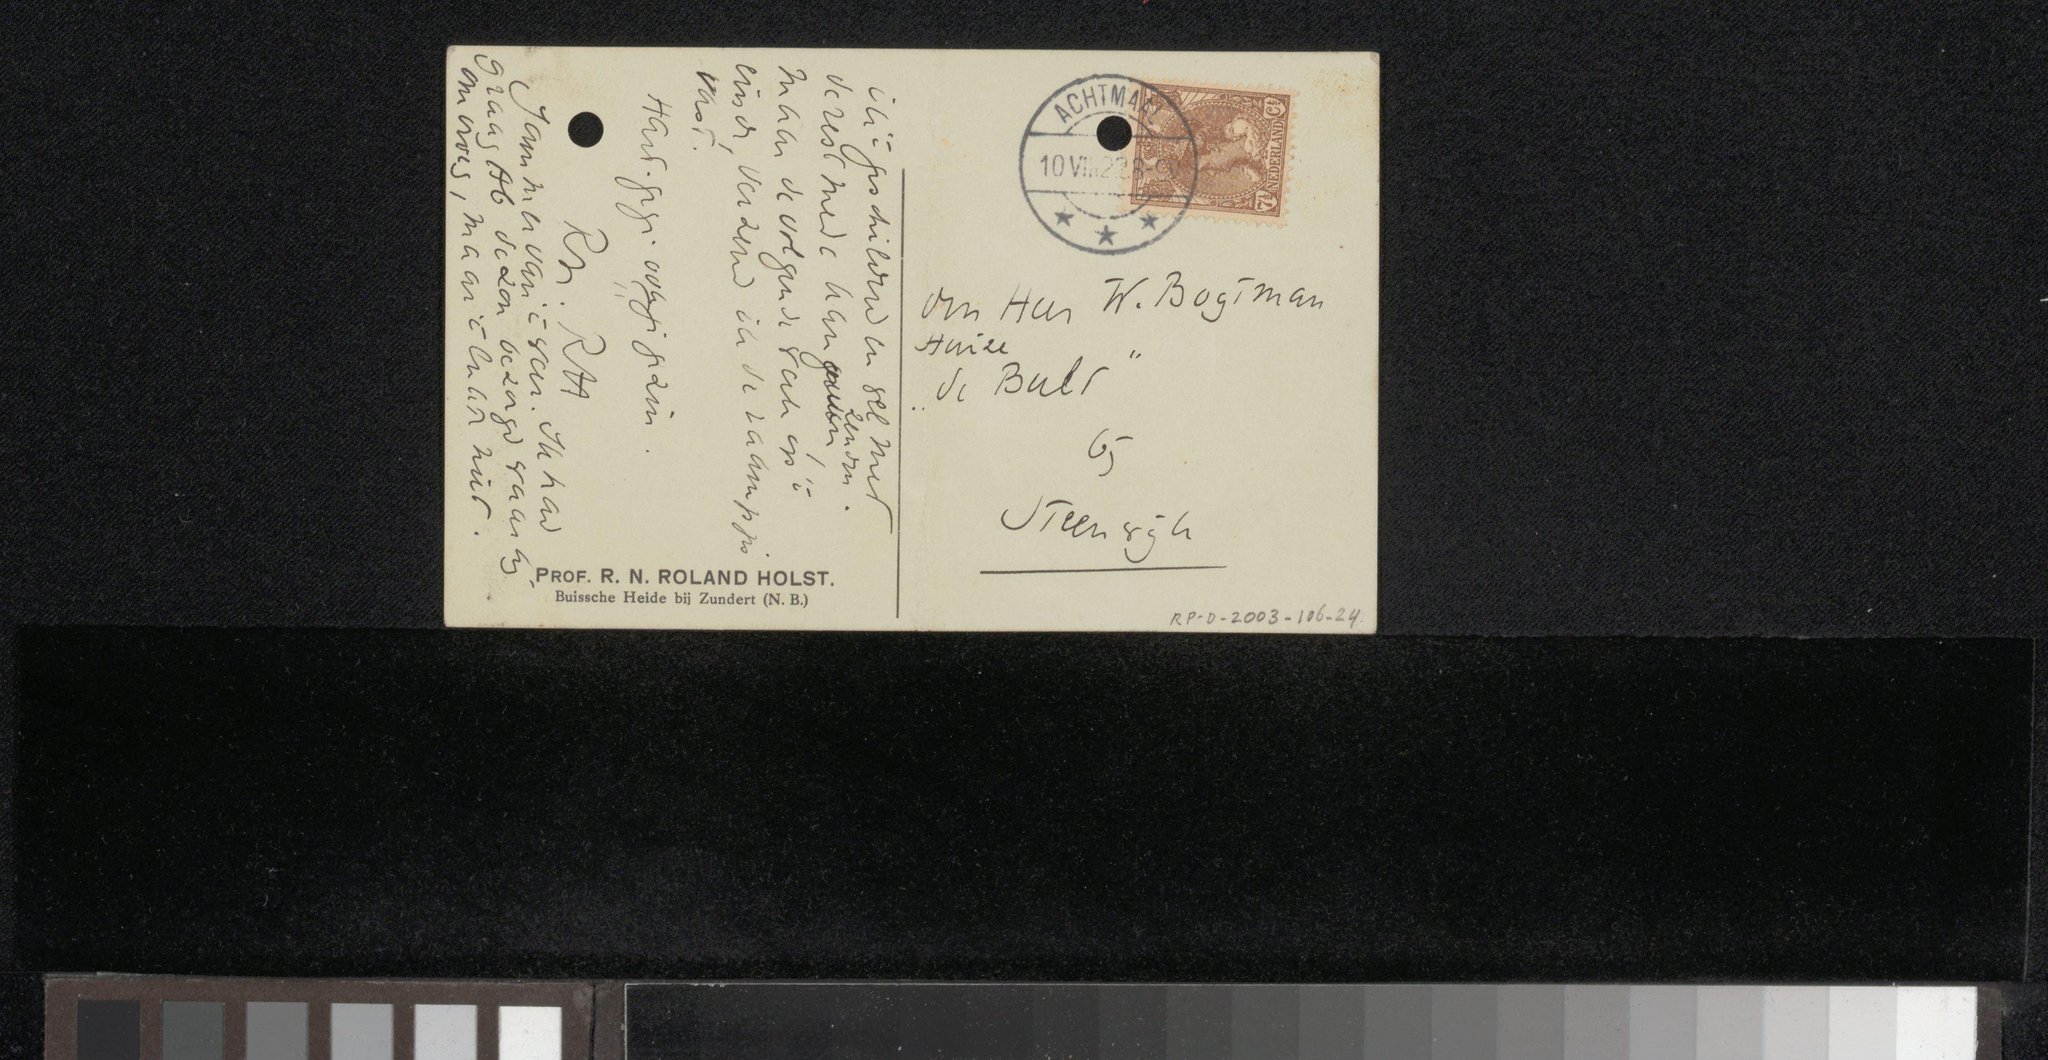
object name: postcard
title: Briefkaart aan Willem Bogtman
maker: richard nicolaüs roland holst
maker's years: 1868-1938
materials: cardboard, ink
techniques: pen, writing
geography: achtmaal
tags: haarlem, willem bogtman, drawing, applied arts, arts and crafts; industrial design